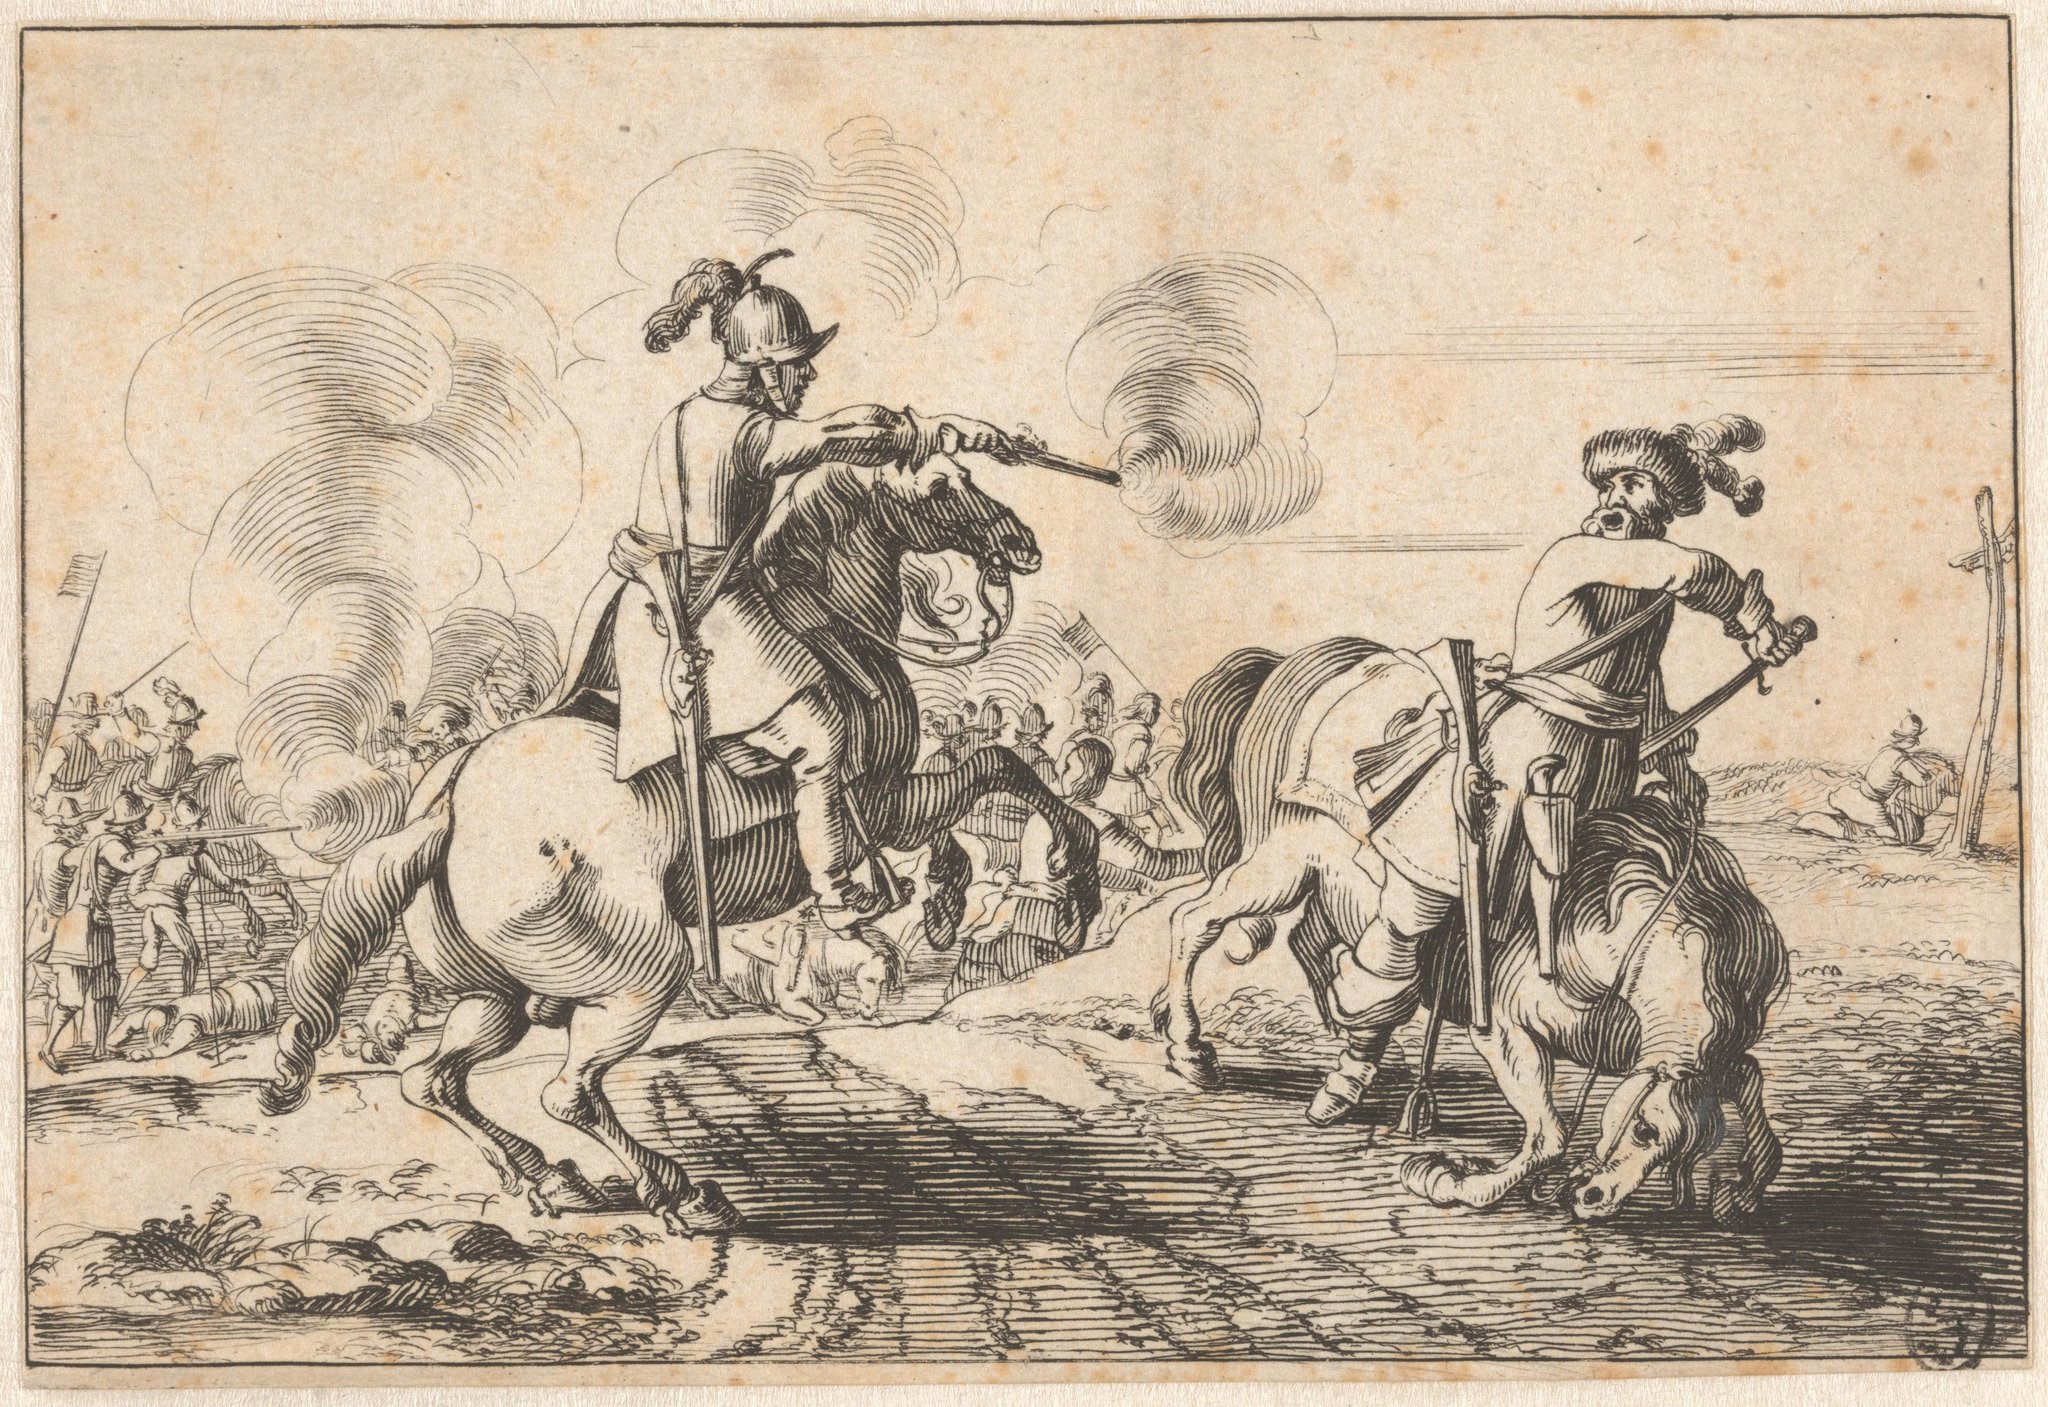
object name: print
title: Batailles et Rencontres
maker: theodorus van kessel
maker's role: print maker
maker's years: 1620-1660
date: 1654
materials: paper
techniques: etching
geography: antwerp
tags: vienna, leopold willem van oostenrijk (landvoogd der zuidelijke nederlanden), hand-to-hand fighting (~ battle) (+ cavalry, horsemen)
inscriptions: collector's mark: Lugt 972, collector's mark: Lugt 2760, collector's mark: Lugt 2228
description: Ruitergevecht met Turken. Onderdeel van een serie van zes prenten over het leger van de landvoogd Leopold Willem, aartshertog van Oostenrijk.